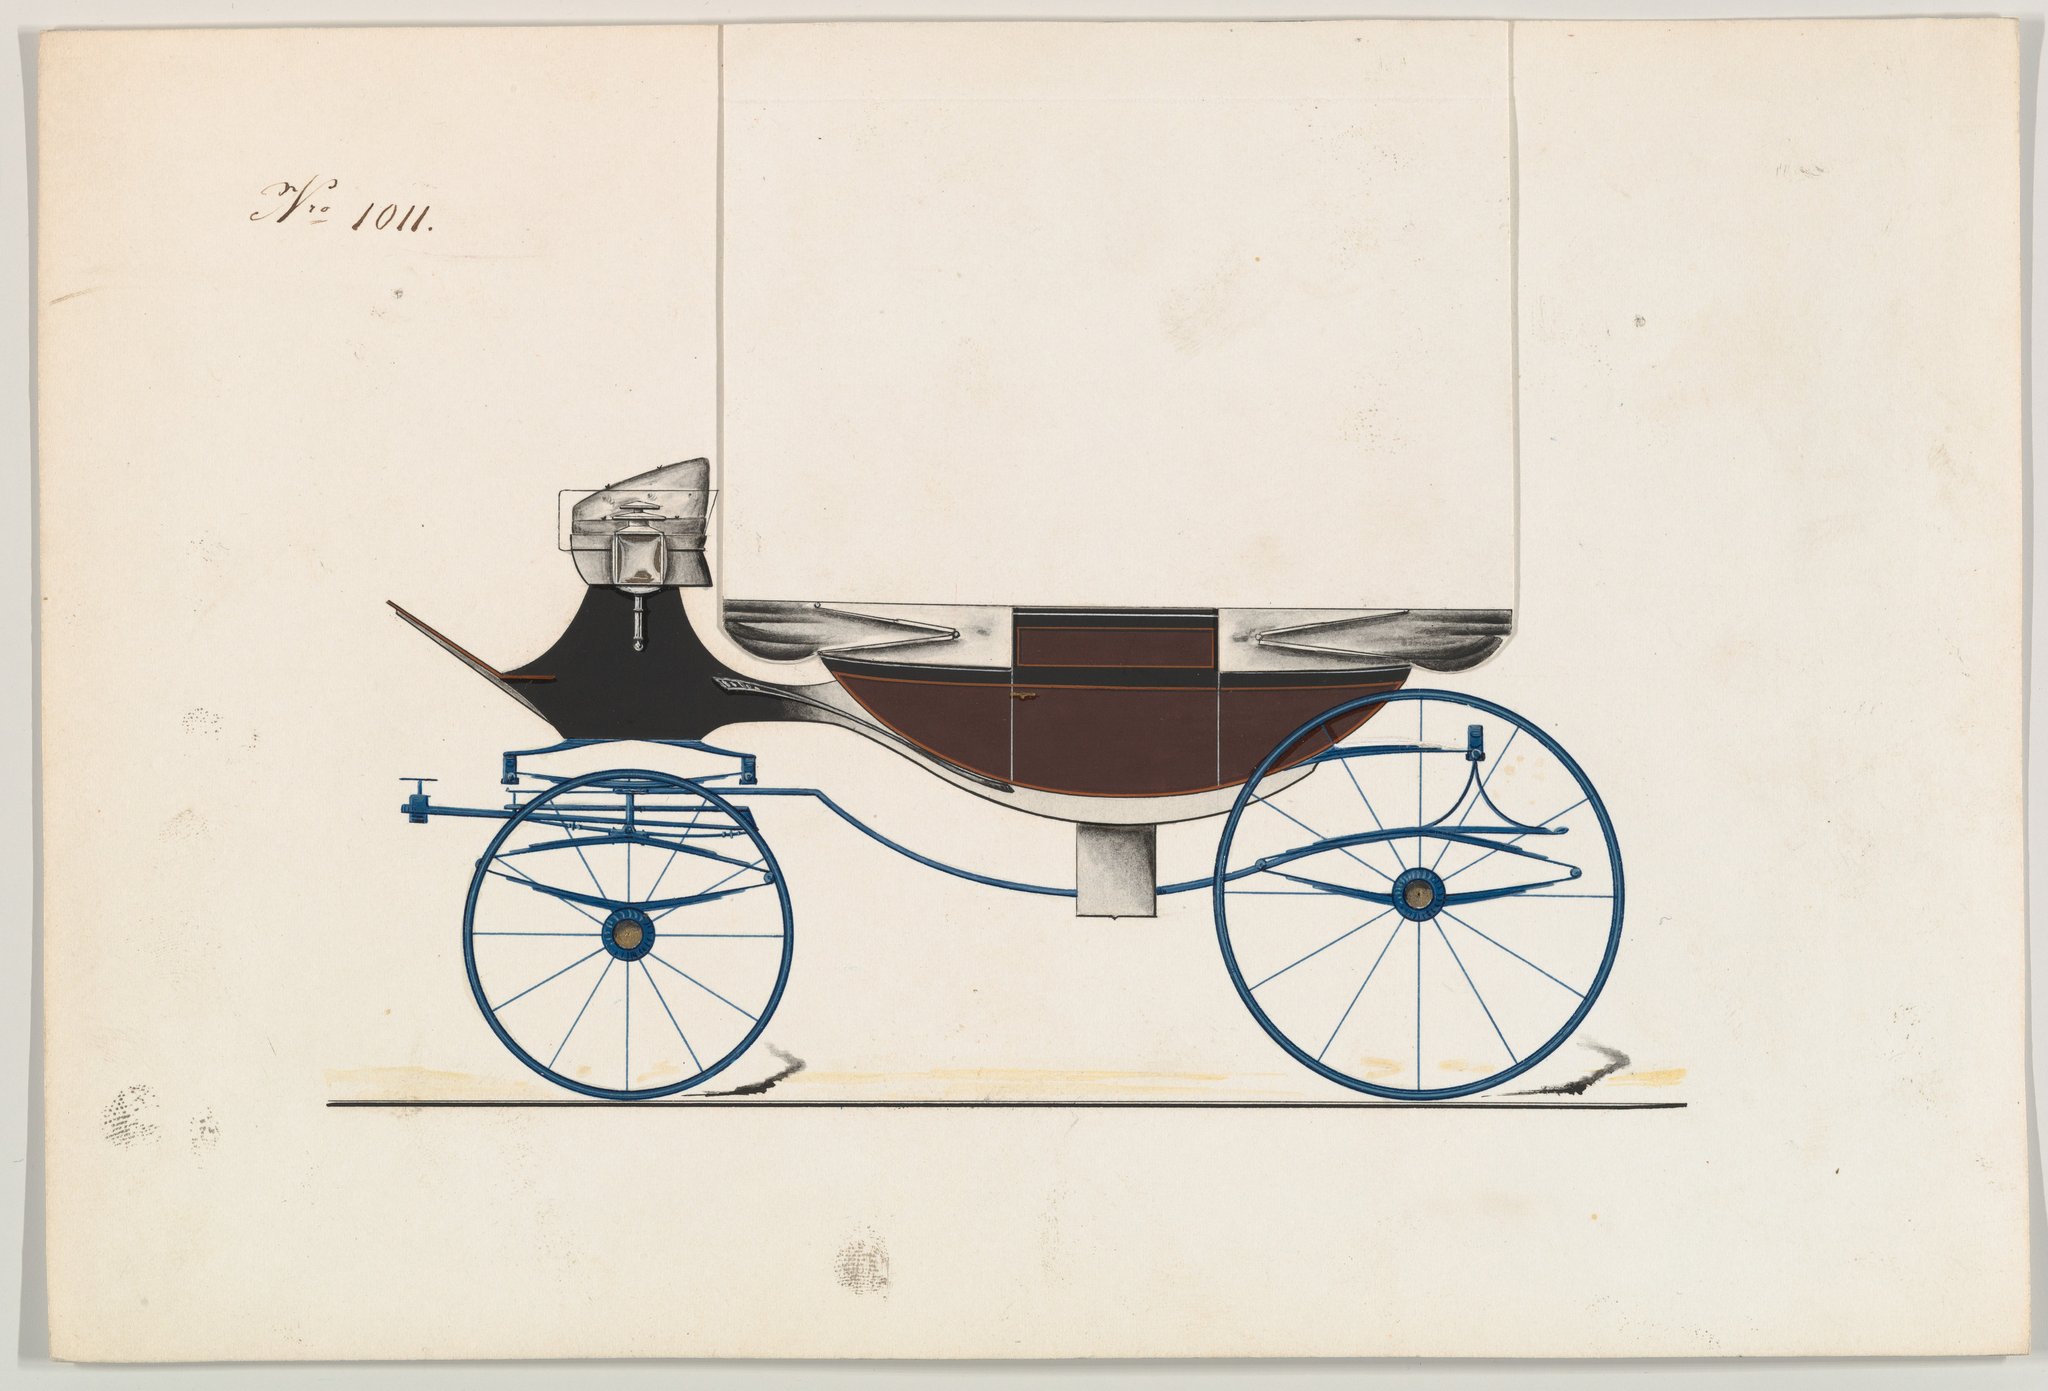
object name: drawing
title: Landau #1011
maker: brewster & co.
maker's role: manufacturer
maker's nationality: american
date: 1850-1870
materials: gouache, gum arabic, ink, watercolor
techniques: pen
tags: carriages